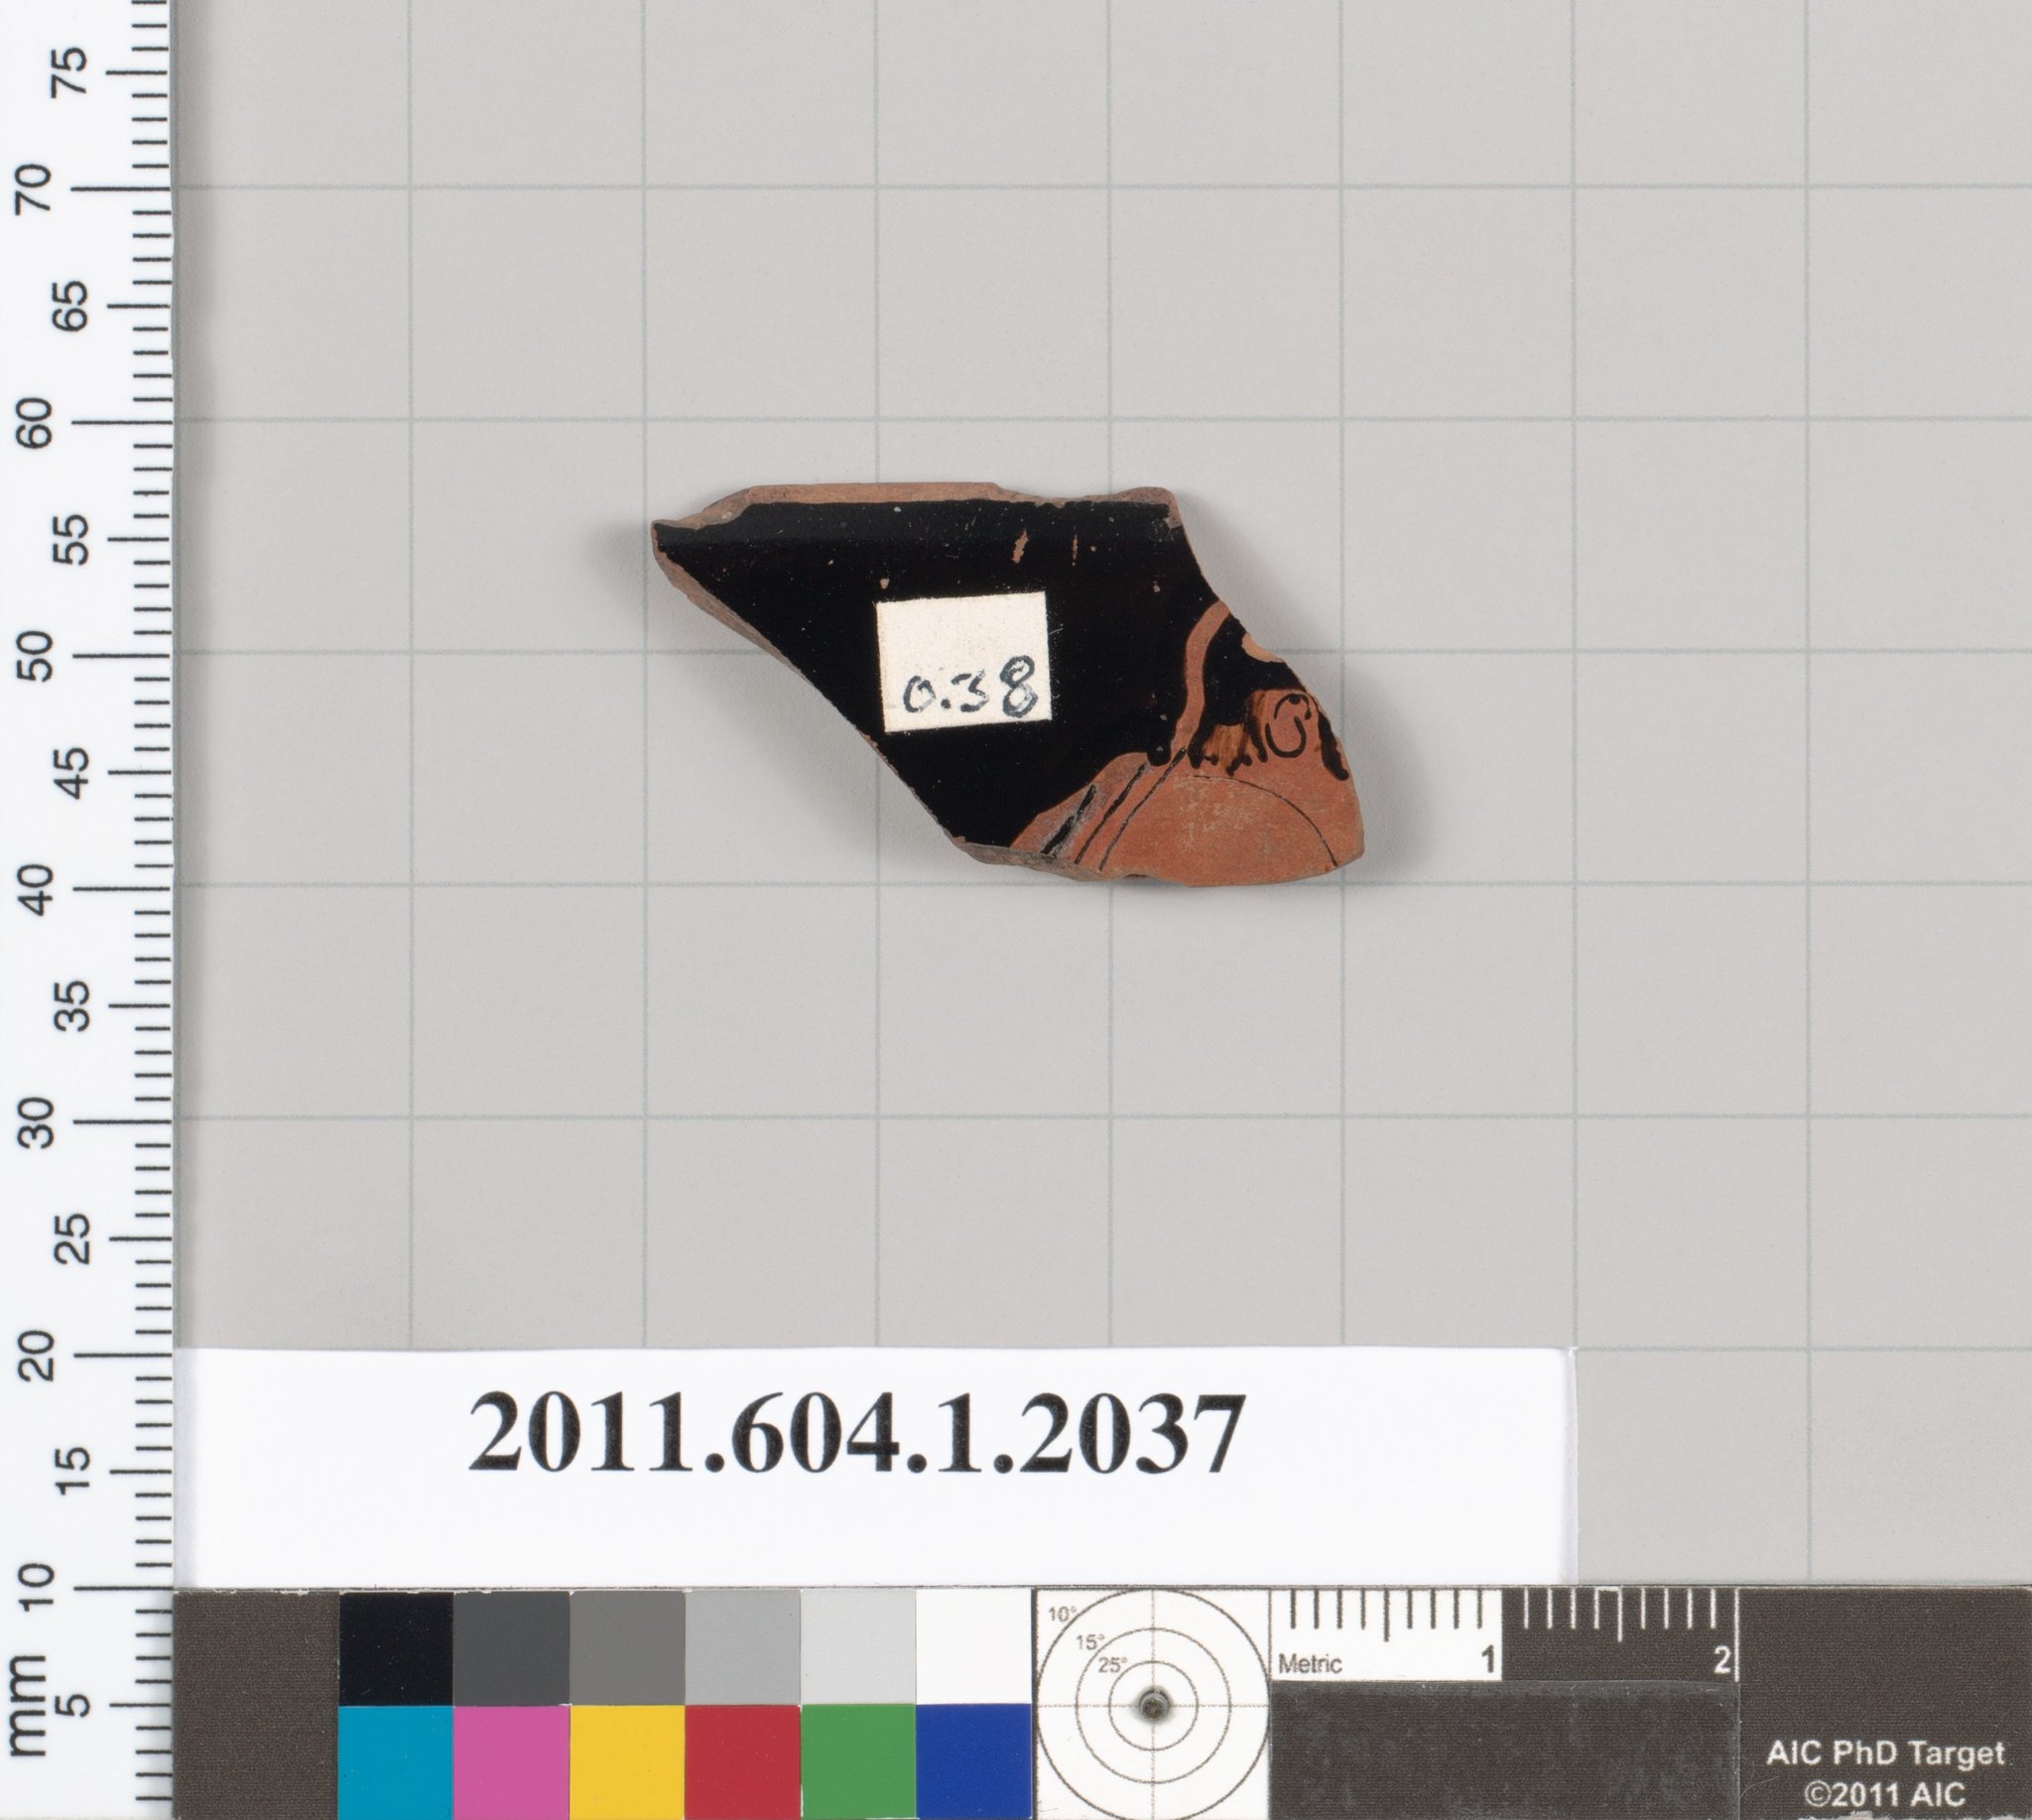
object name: kylix fragment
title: Terracotta rim fragment of a kylix (drinking cup)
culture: greek, attic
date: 475-451 BCE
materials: terracotta